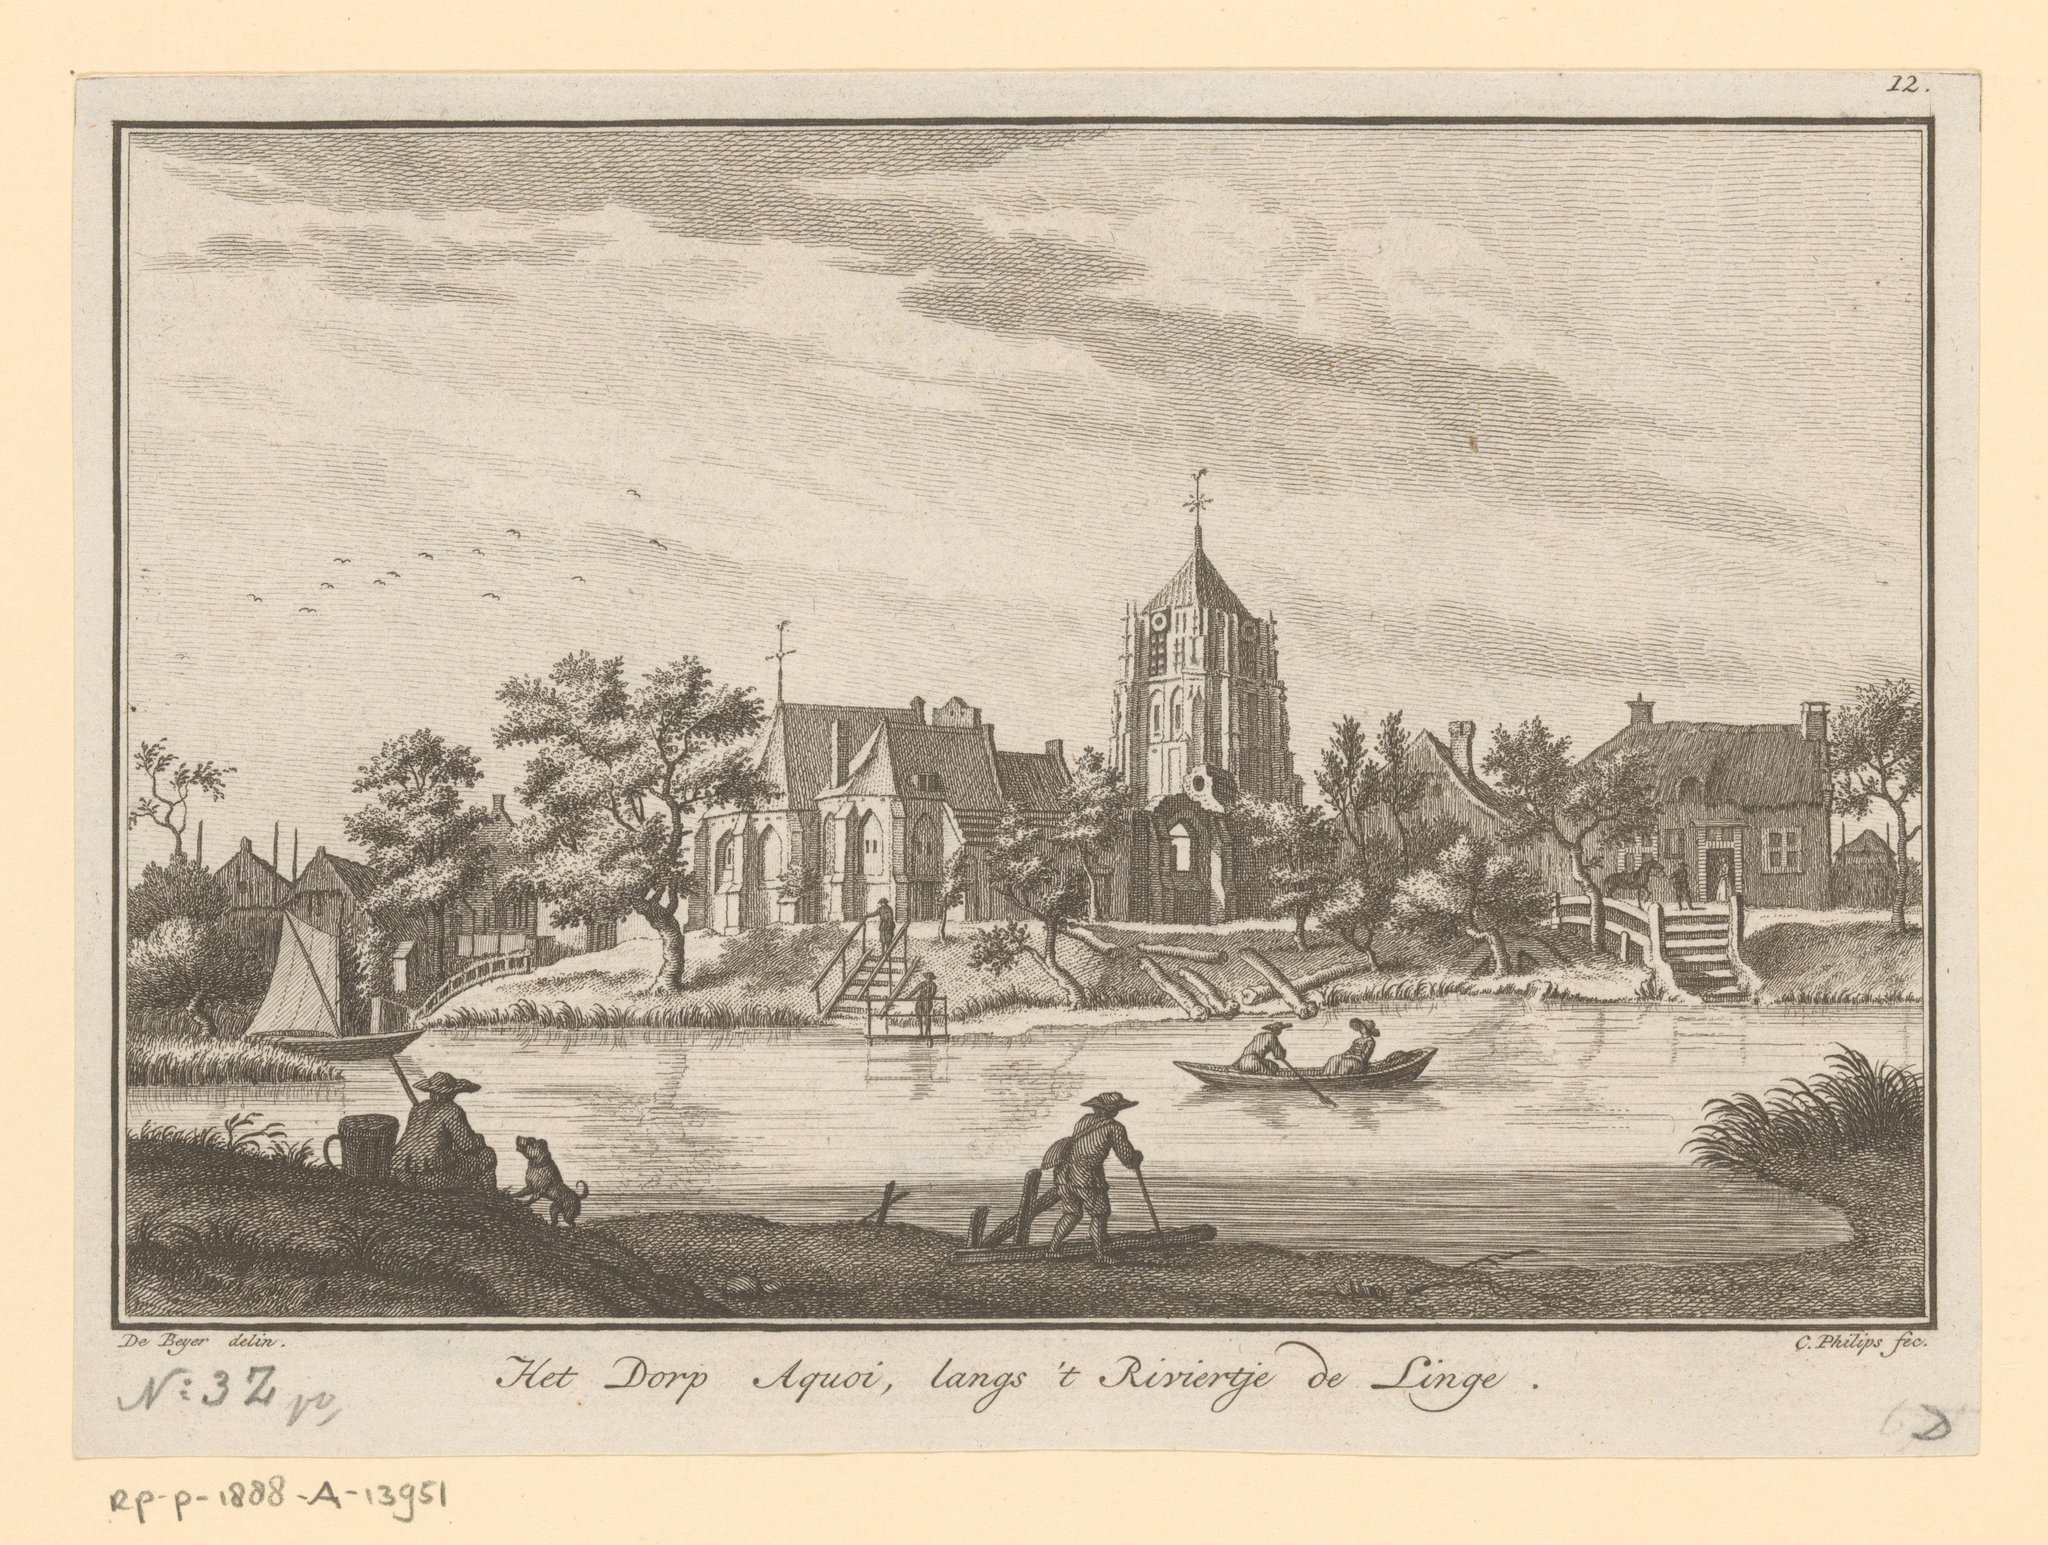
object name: print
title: Het Dorp Aquoi, langs 't Riviertje de Linge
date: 1740-1760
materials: paper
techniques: etching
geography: amsterdam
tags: city-view, and landscape with man-made constructions, church (exterior)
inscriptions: collector's mark: Lugt 2233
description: Prent verschenen in: Salmon, Th. Hedendaagsche historie of tegenwoordige staat van alle volkeren (...). 44 dln. Amsterdam: Isaak Tirion, 1730-1803.